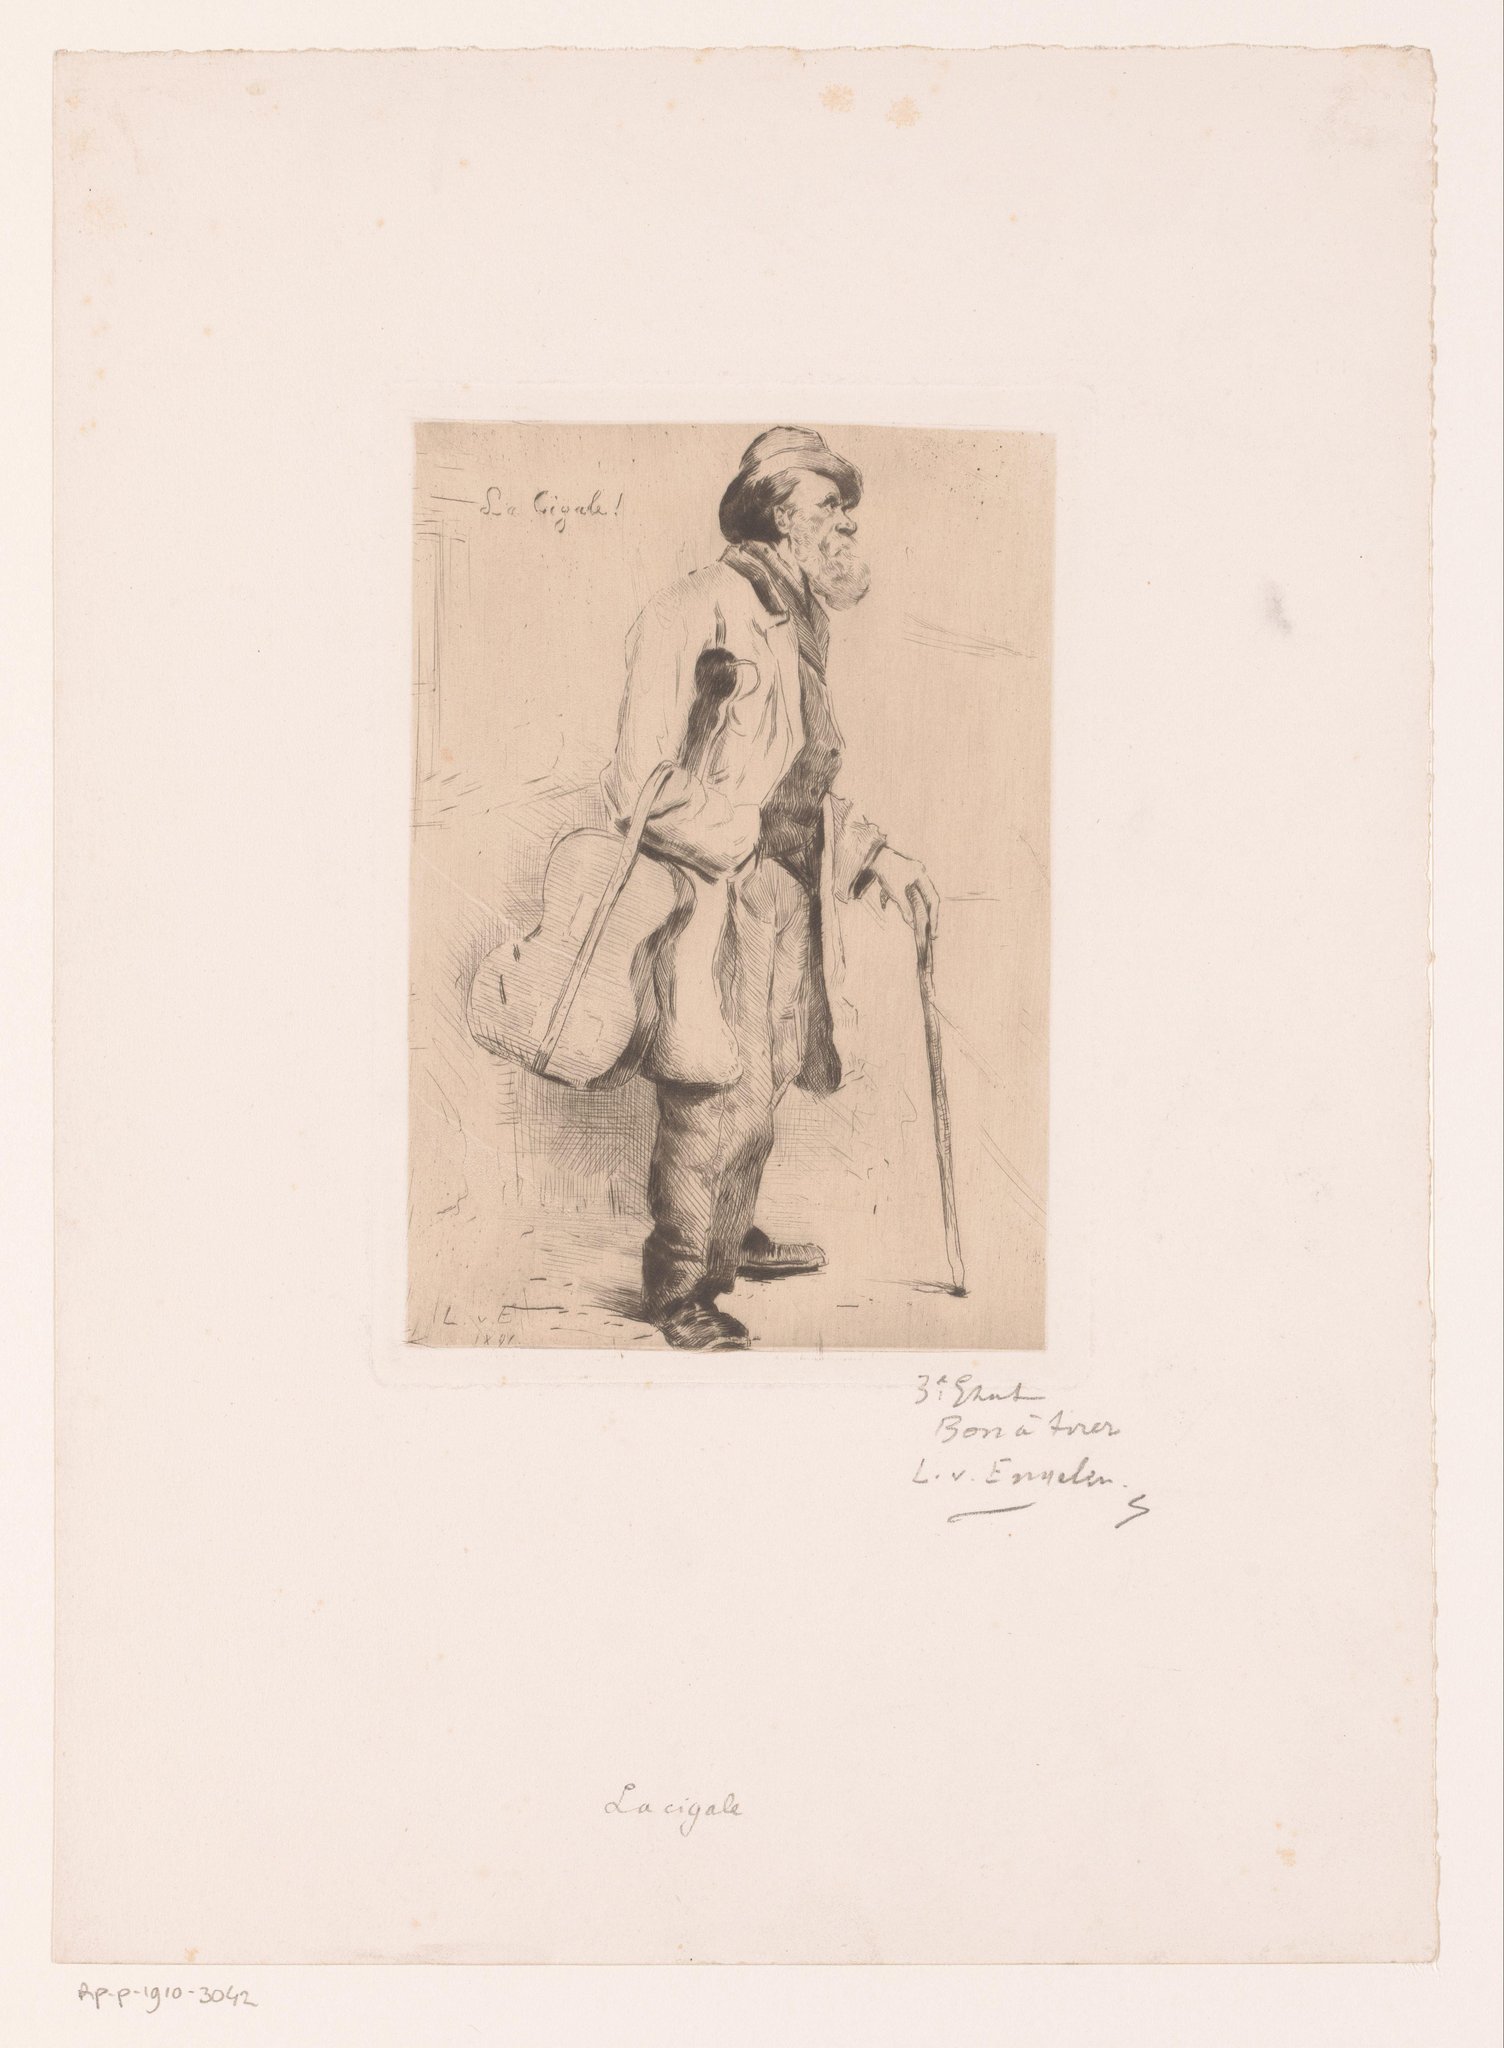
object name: print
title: La Cigale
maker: louis van engelen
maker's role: print maker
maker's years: 1856-1940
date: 1866-1910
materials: paper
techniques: drypoint, etching, intaglio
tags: walking-stick, staff, old man, cithern, mandolin, guitar, balalaika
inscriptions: inscription: ‘3e Etat Bon à tirer’, collector's mark: Lugt 2228